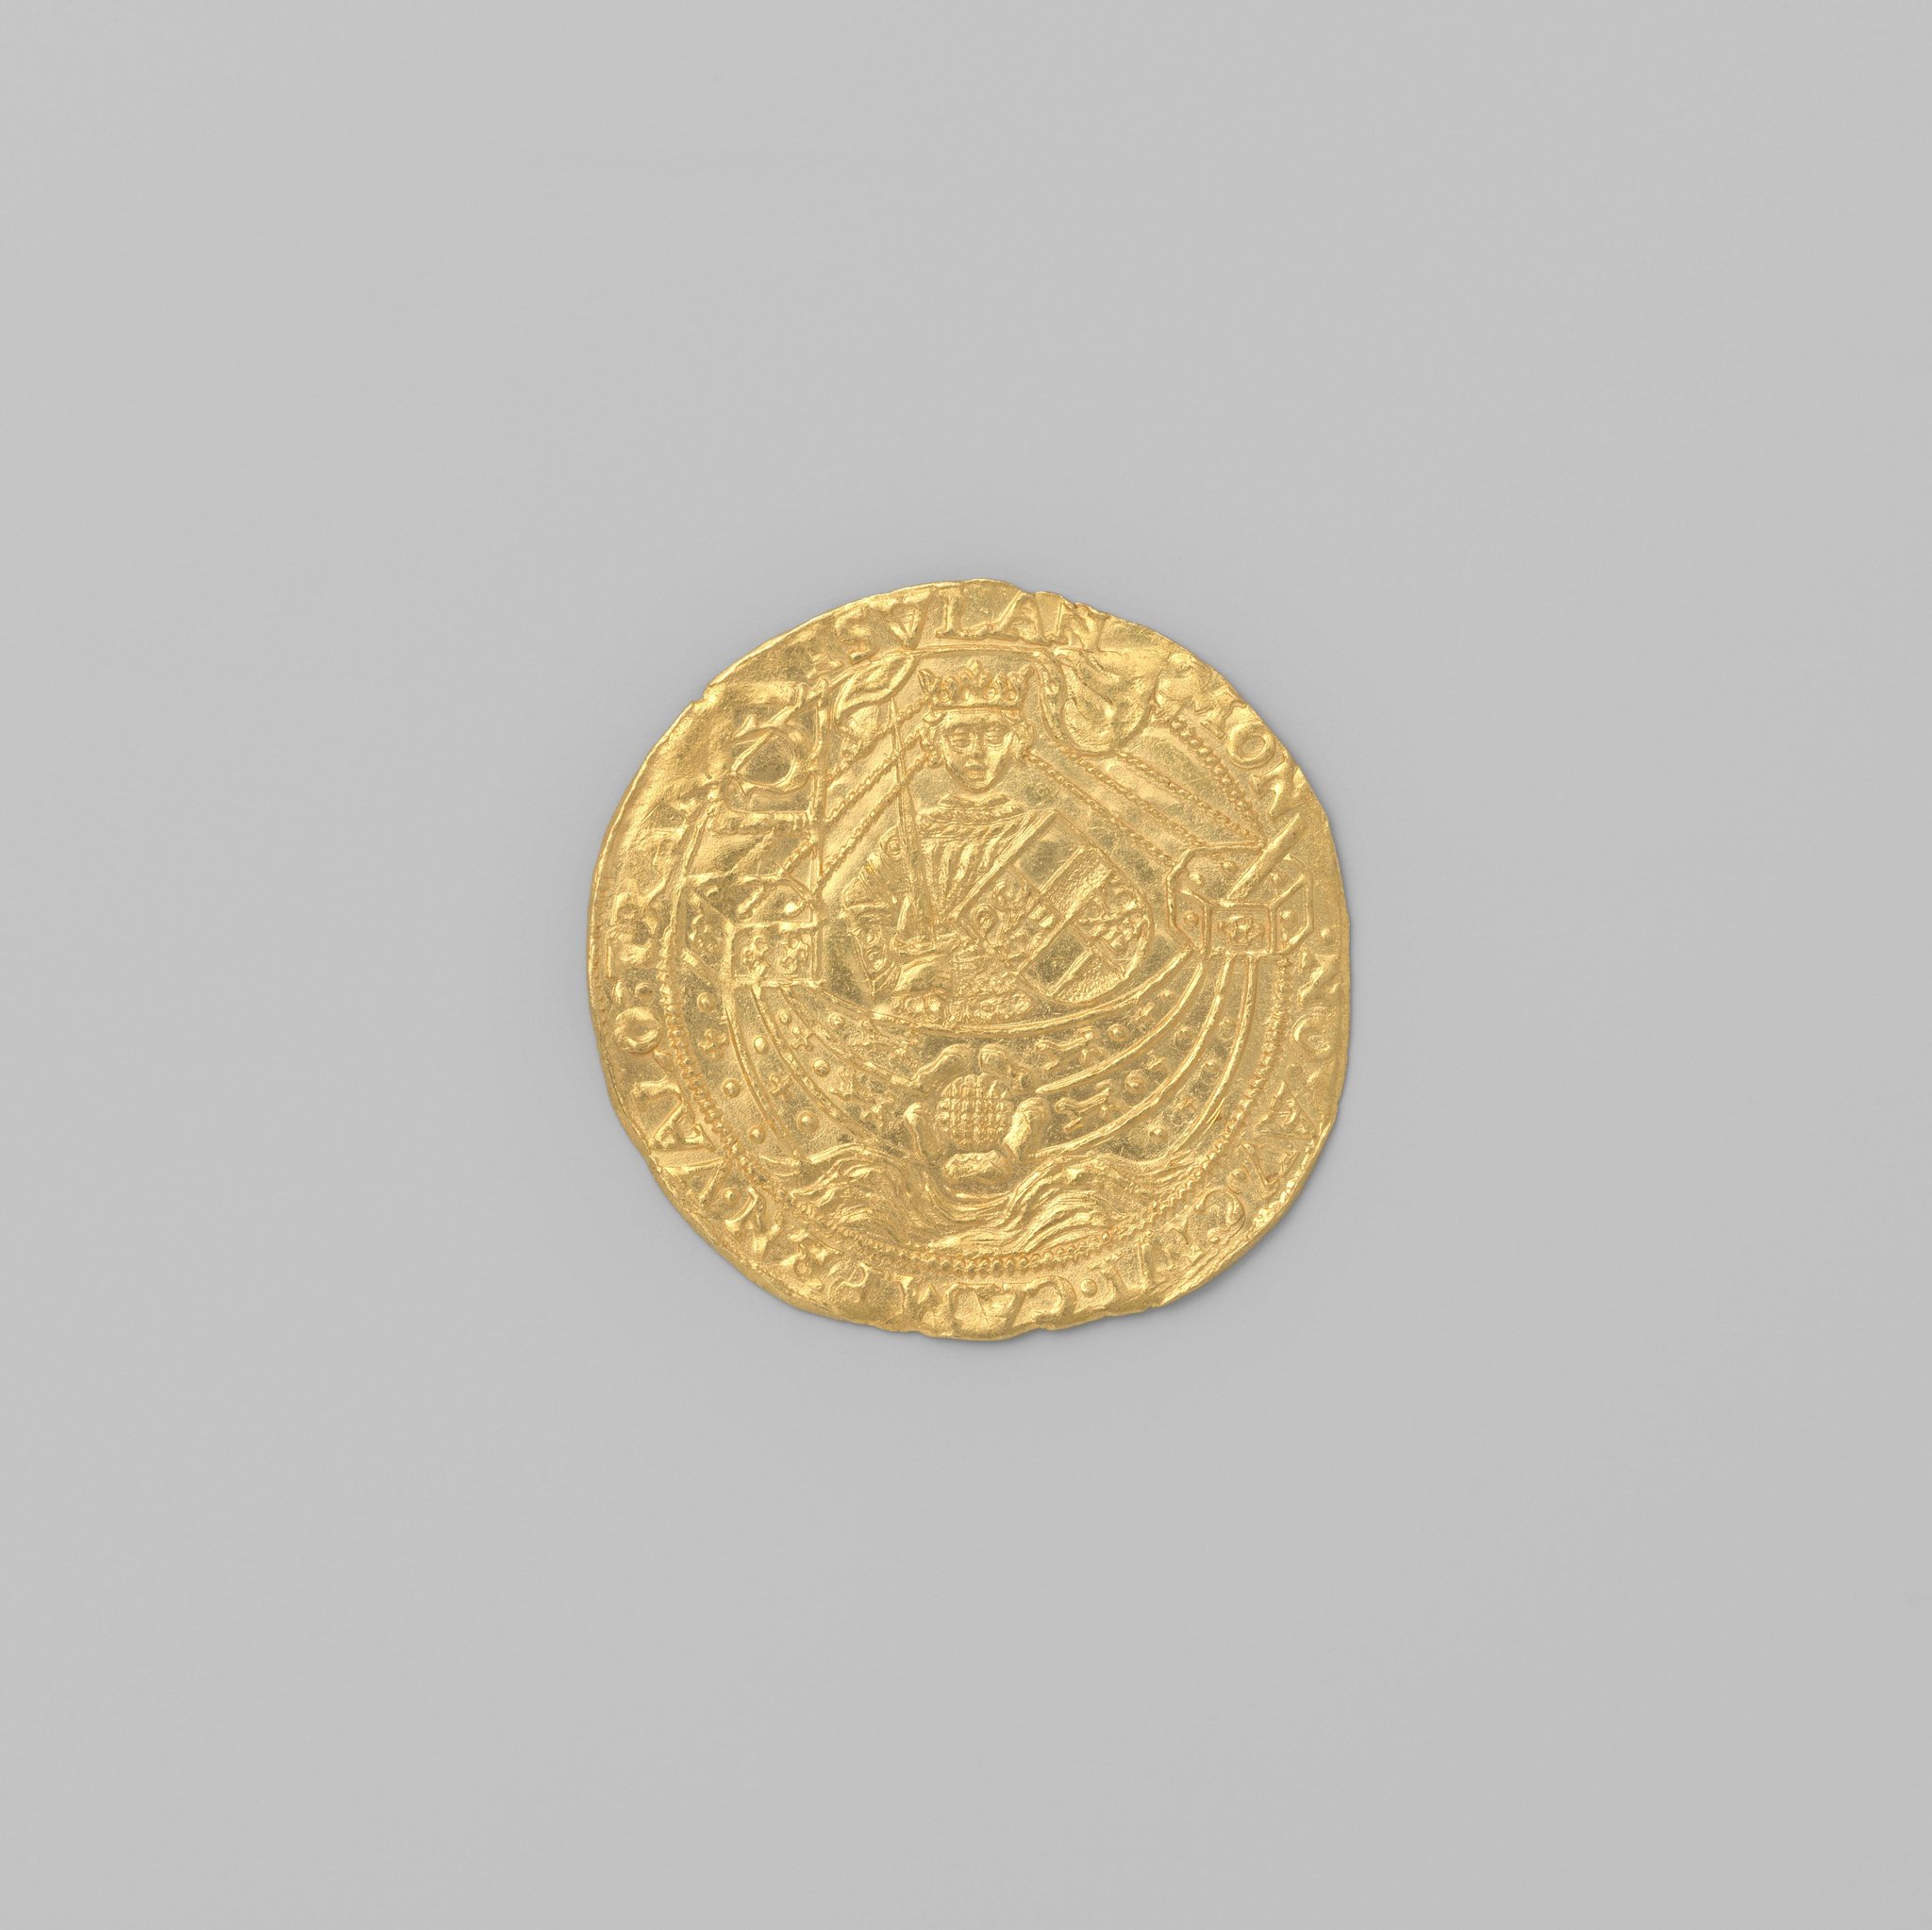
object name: coin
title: Gouden rozenobel Kampen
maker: Anonymous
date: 1600-1602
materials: gold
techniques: striking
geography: europe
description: Gouden handelsmunt afkomstig uit Nederlandse schatvondst (Randwijk).